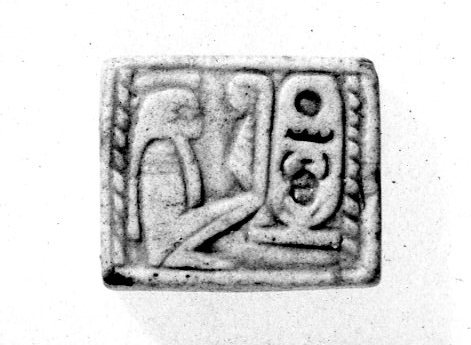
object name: plaque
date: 664-332 BCE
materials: glass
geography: egypt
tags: cartouches,hieroglyphs